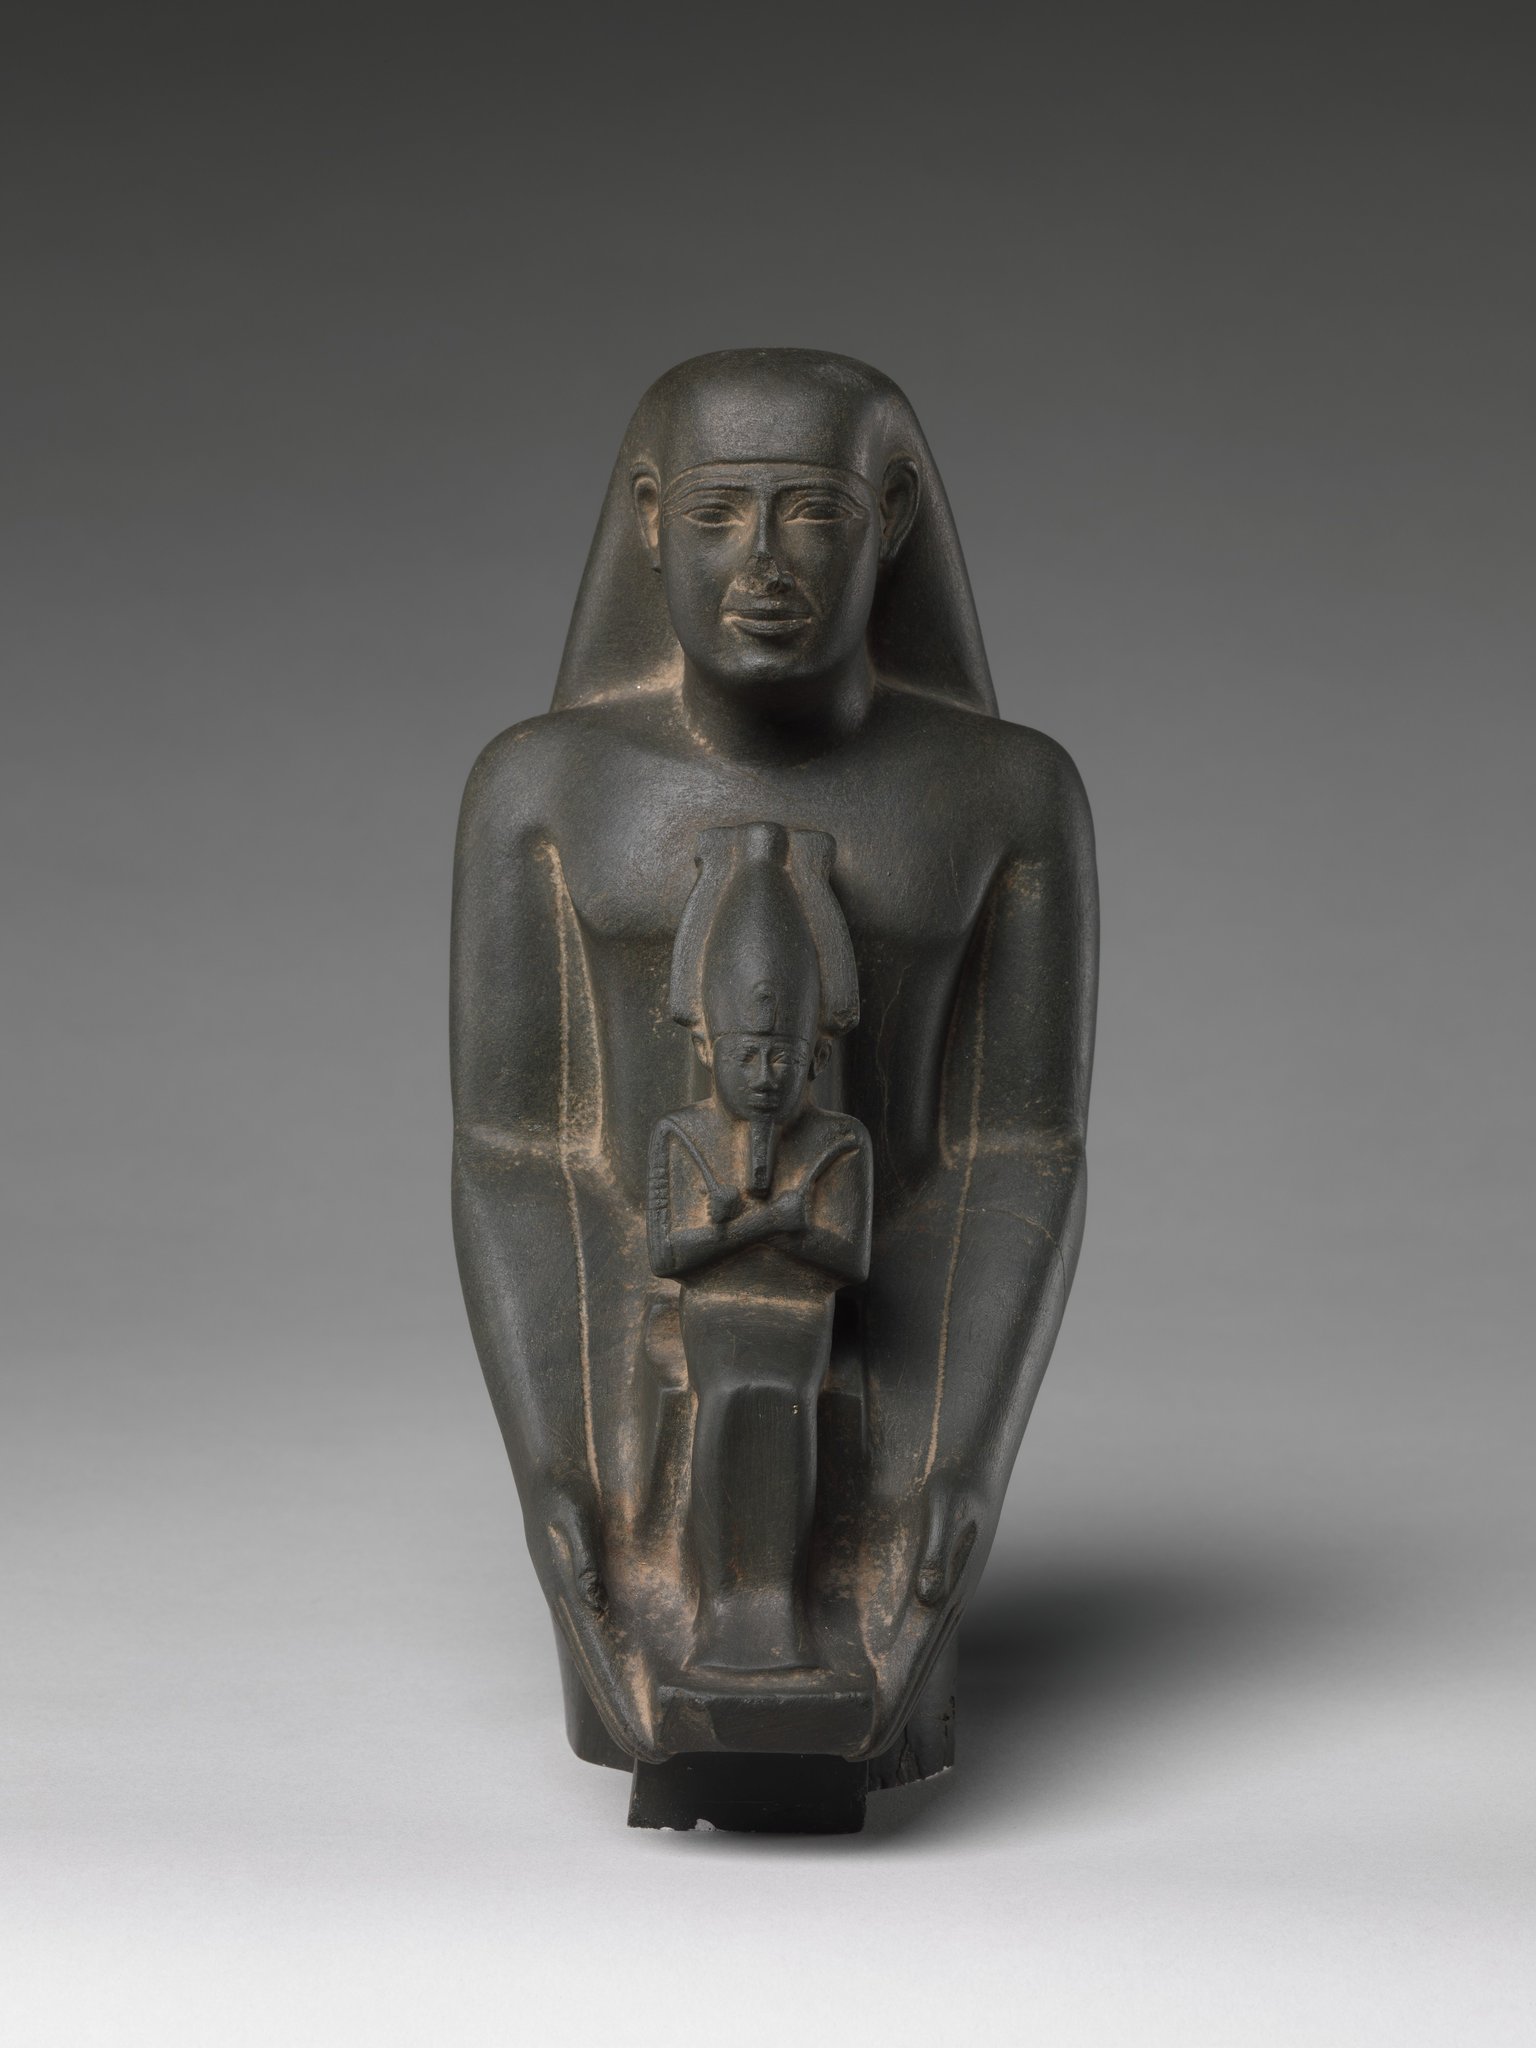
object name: statue, padiamunrenebwaset, osiris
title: Padiamunrenebwaset, son of Irethoreru, holding a seated statue of Osiris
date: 301-400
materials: stone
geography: egypt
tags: men